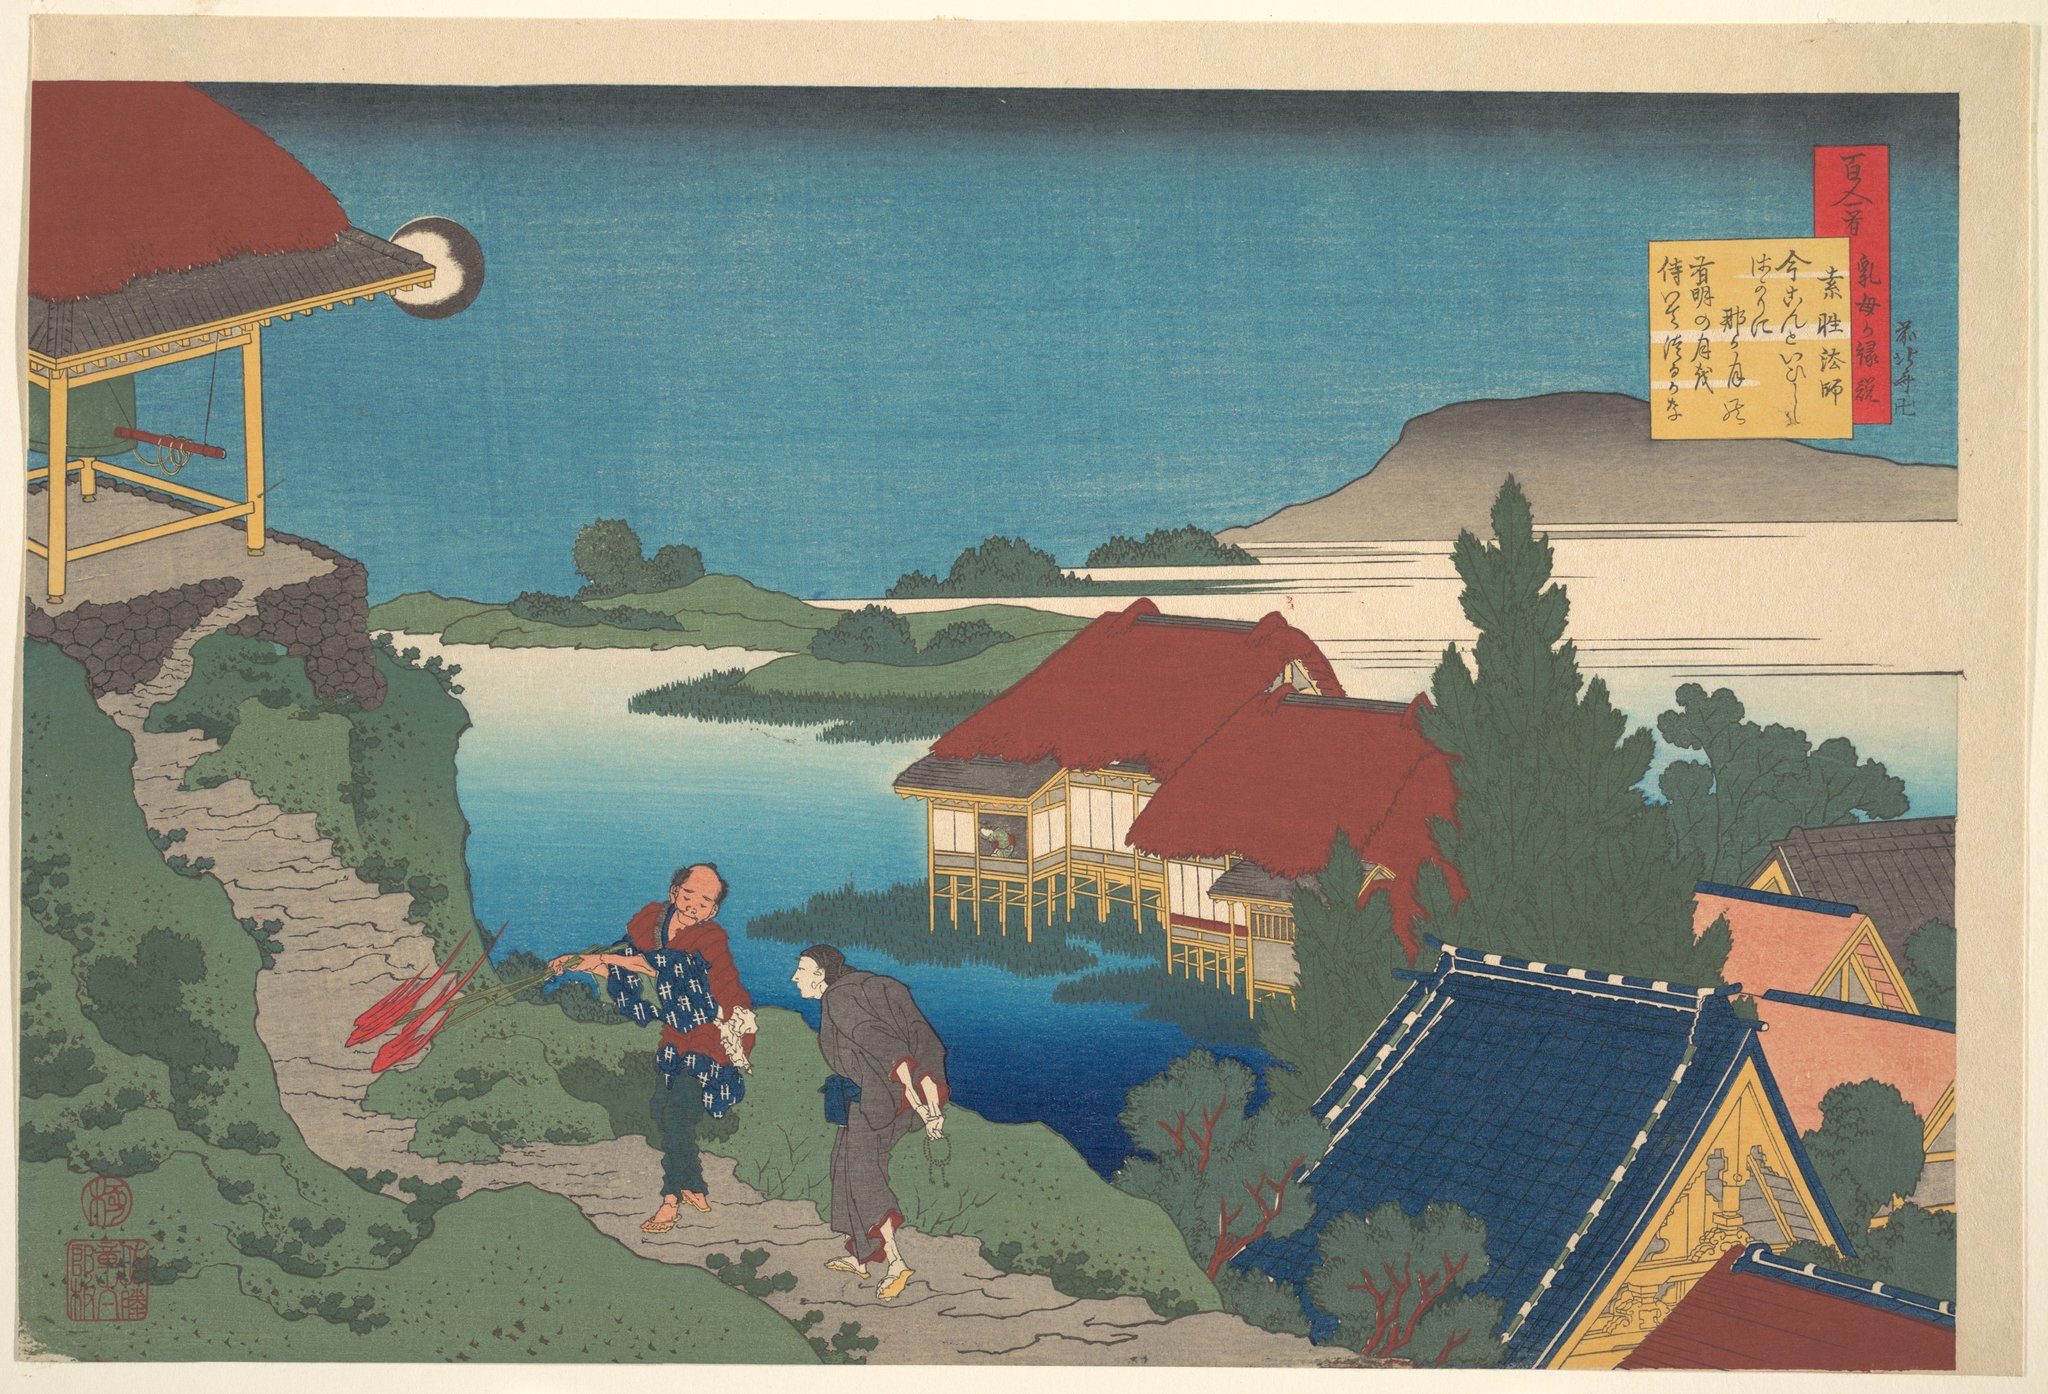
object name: woodblock print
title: Poem by Sōsei Hōshi, from the series One Hundred Poems Explained by the Nurse (Hyakunin isshu uba ga etoki)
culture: japanese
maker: katsushika hokusai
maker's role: artist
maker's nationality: japanese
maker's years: 1760-1849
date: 1921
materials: ink, paper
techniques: woodblock print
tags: buildings,men,landscapes